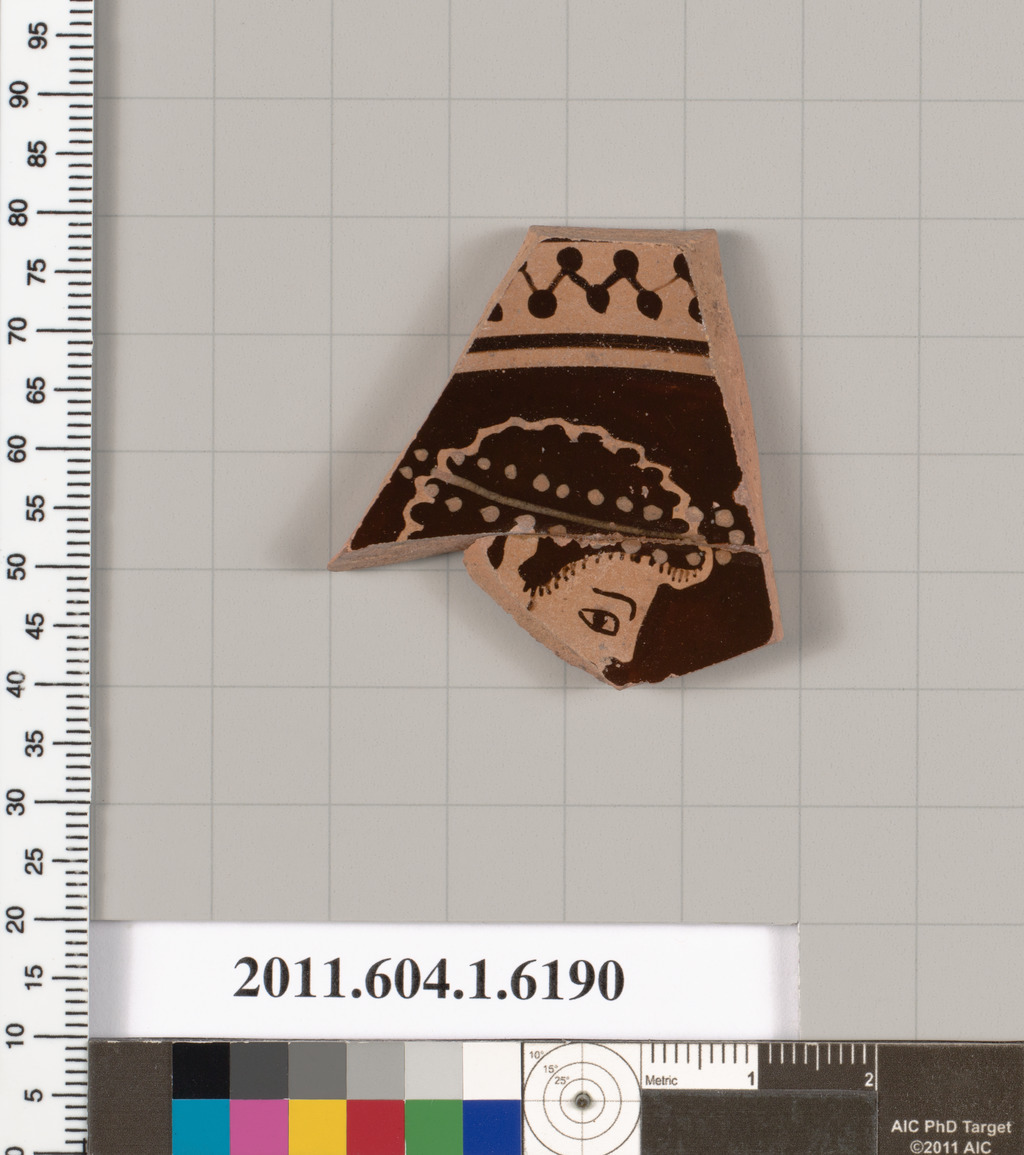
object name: kylix fragment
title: Terracotta fragment of a kylix (drinking cup)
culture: greek, attic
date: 520-510 BCE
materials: terracotta